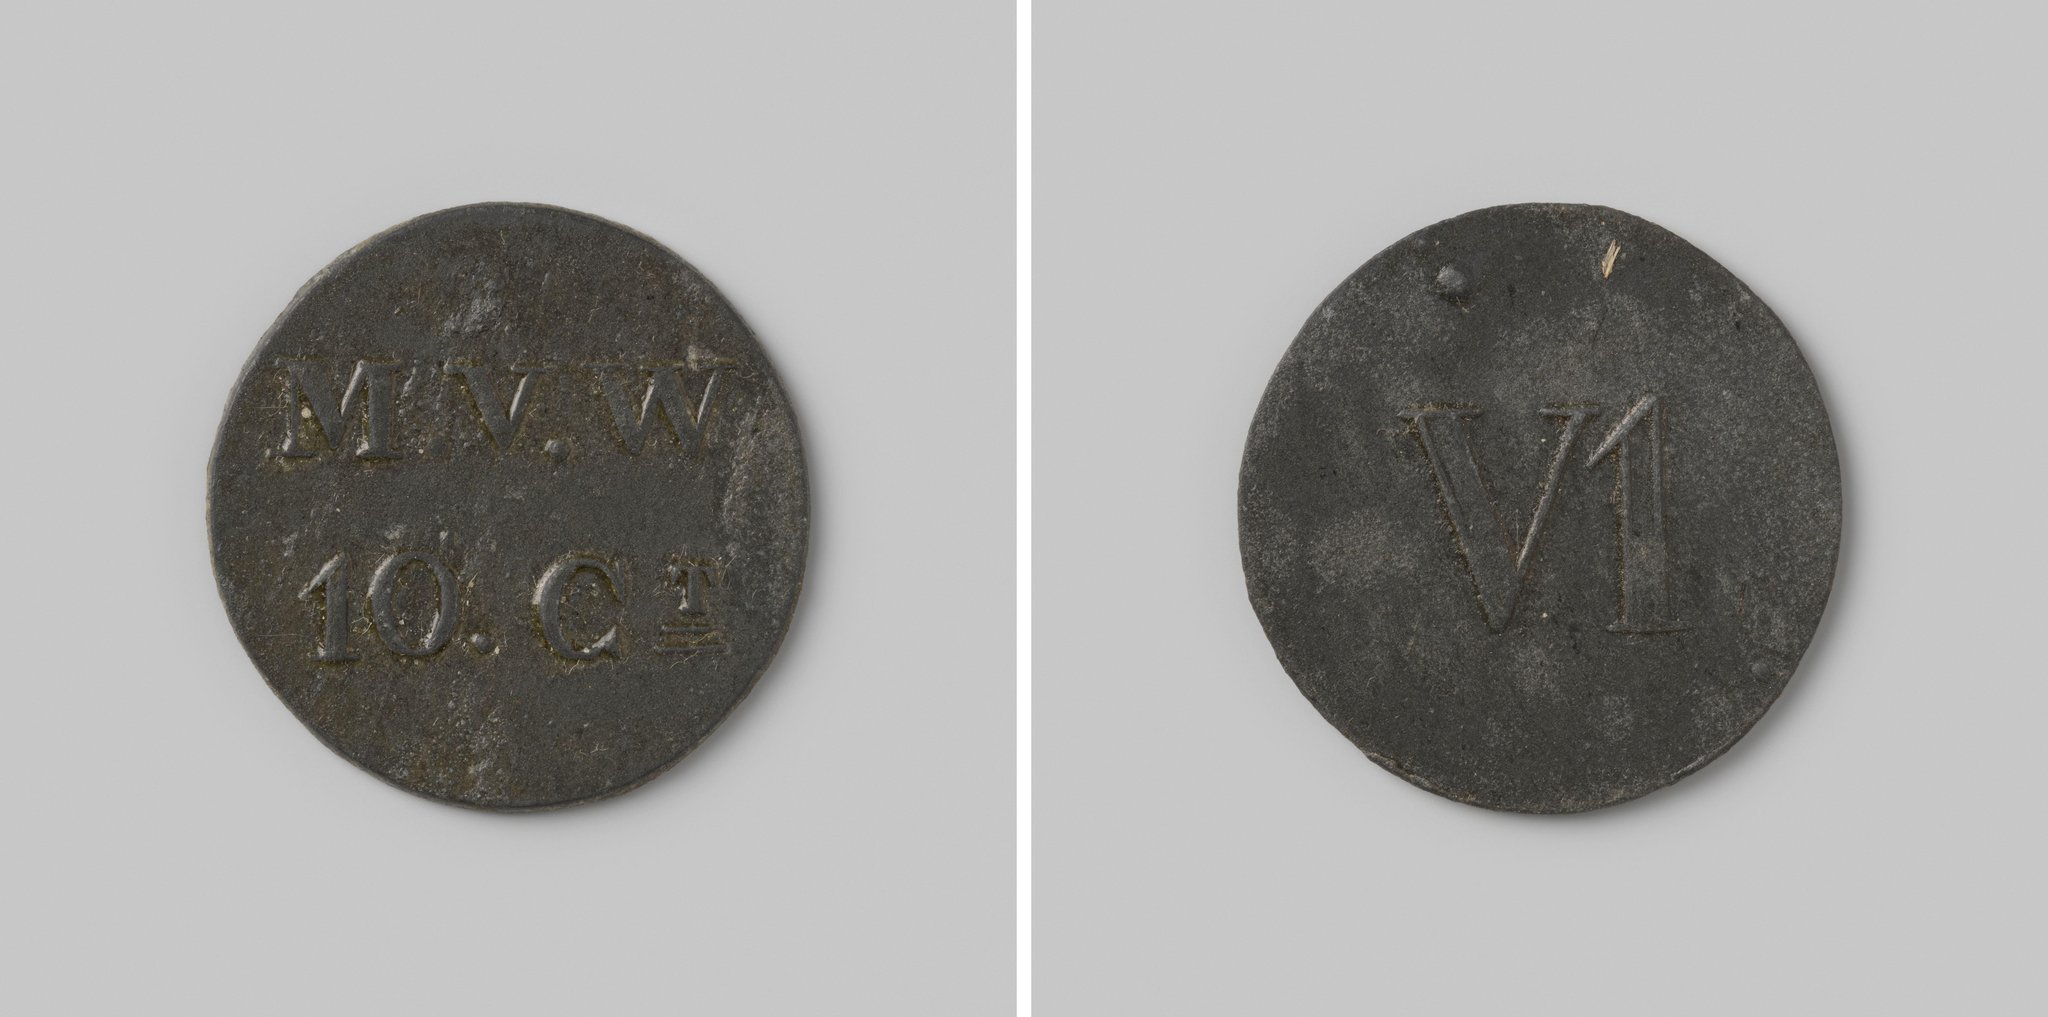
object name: history medal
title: Betaalpenning van 10 cent van de Maatschappij van Weldadigheid V1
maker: Anonymous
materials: zinc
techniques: striking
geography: veenhuizen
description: Zinken penning, op de voorzijde in twee regels M.V.W. / 10. Ct, op de keerzijde V1